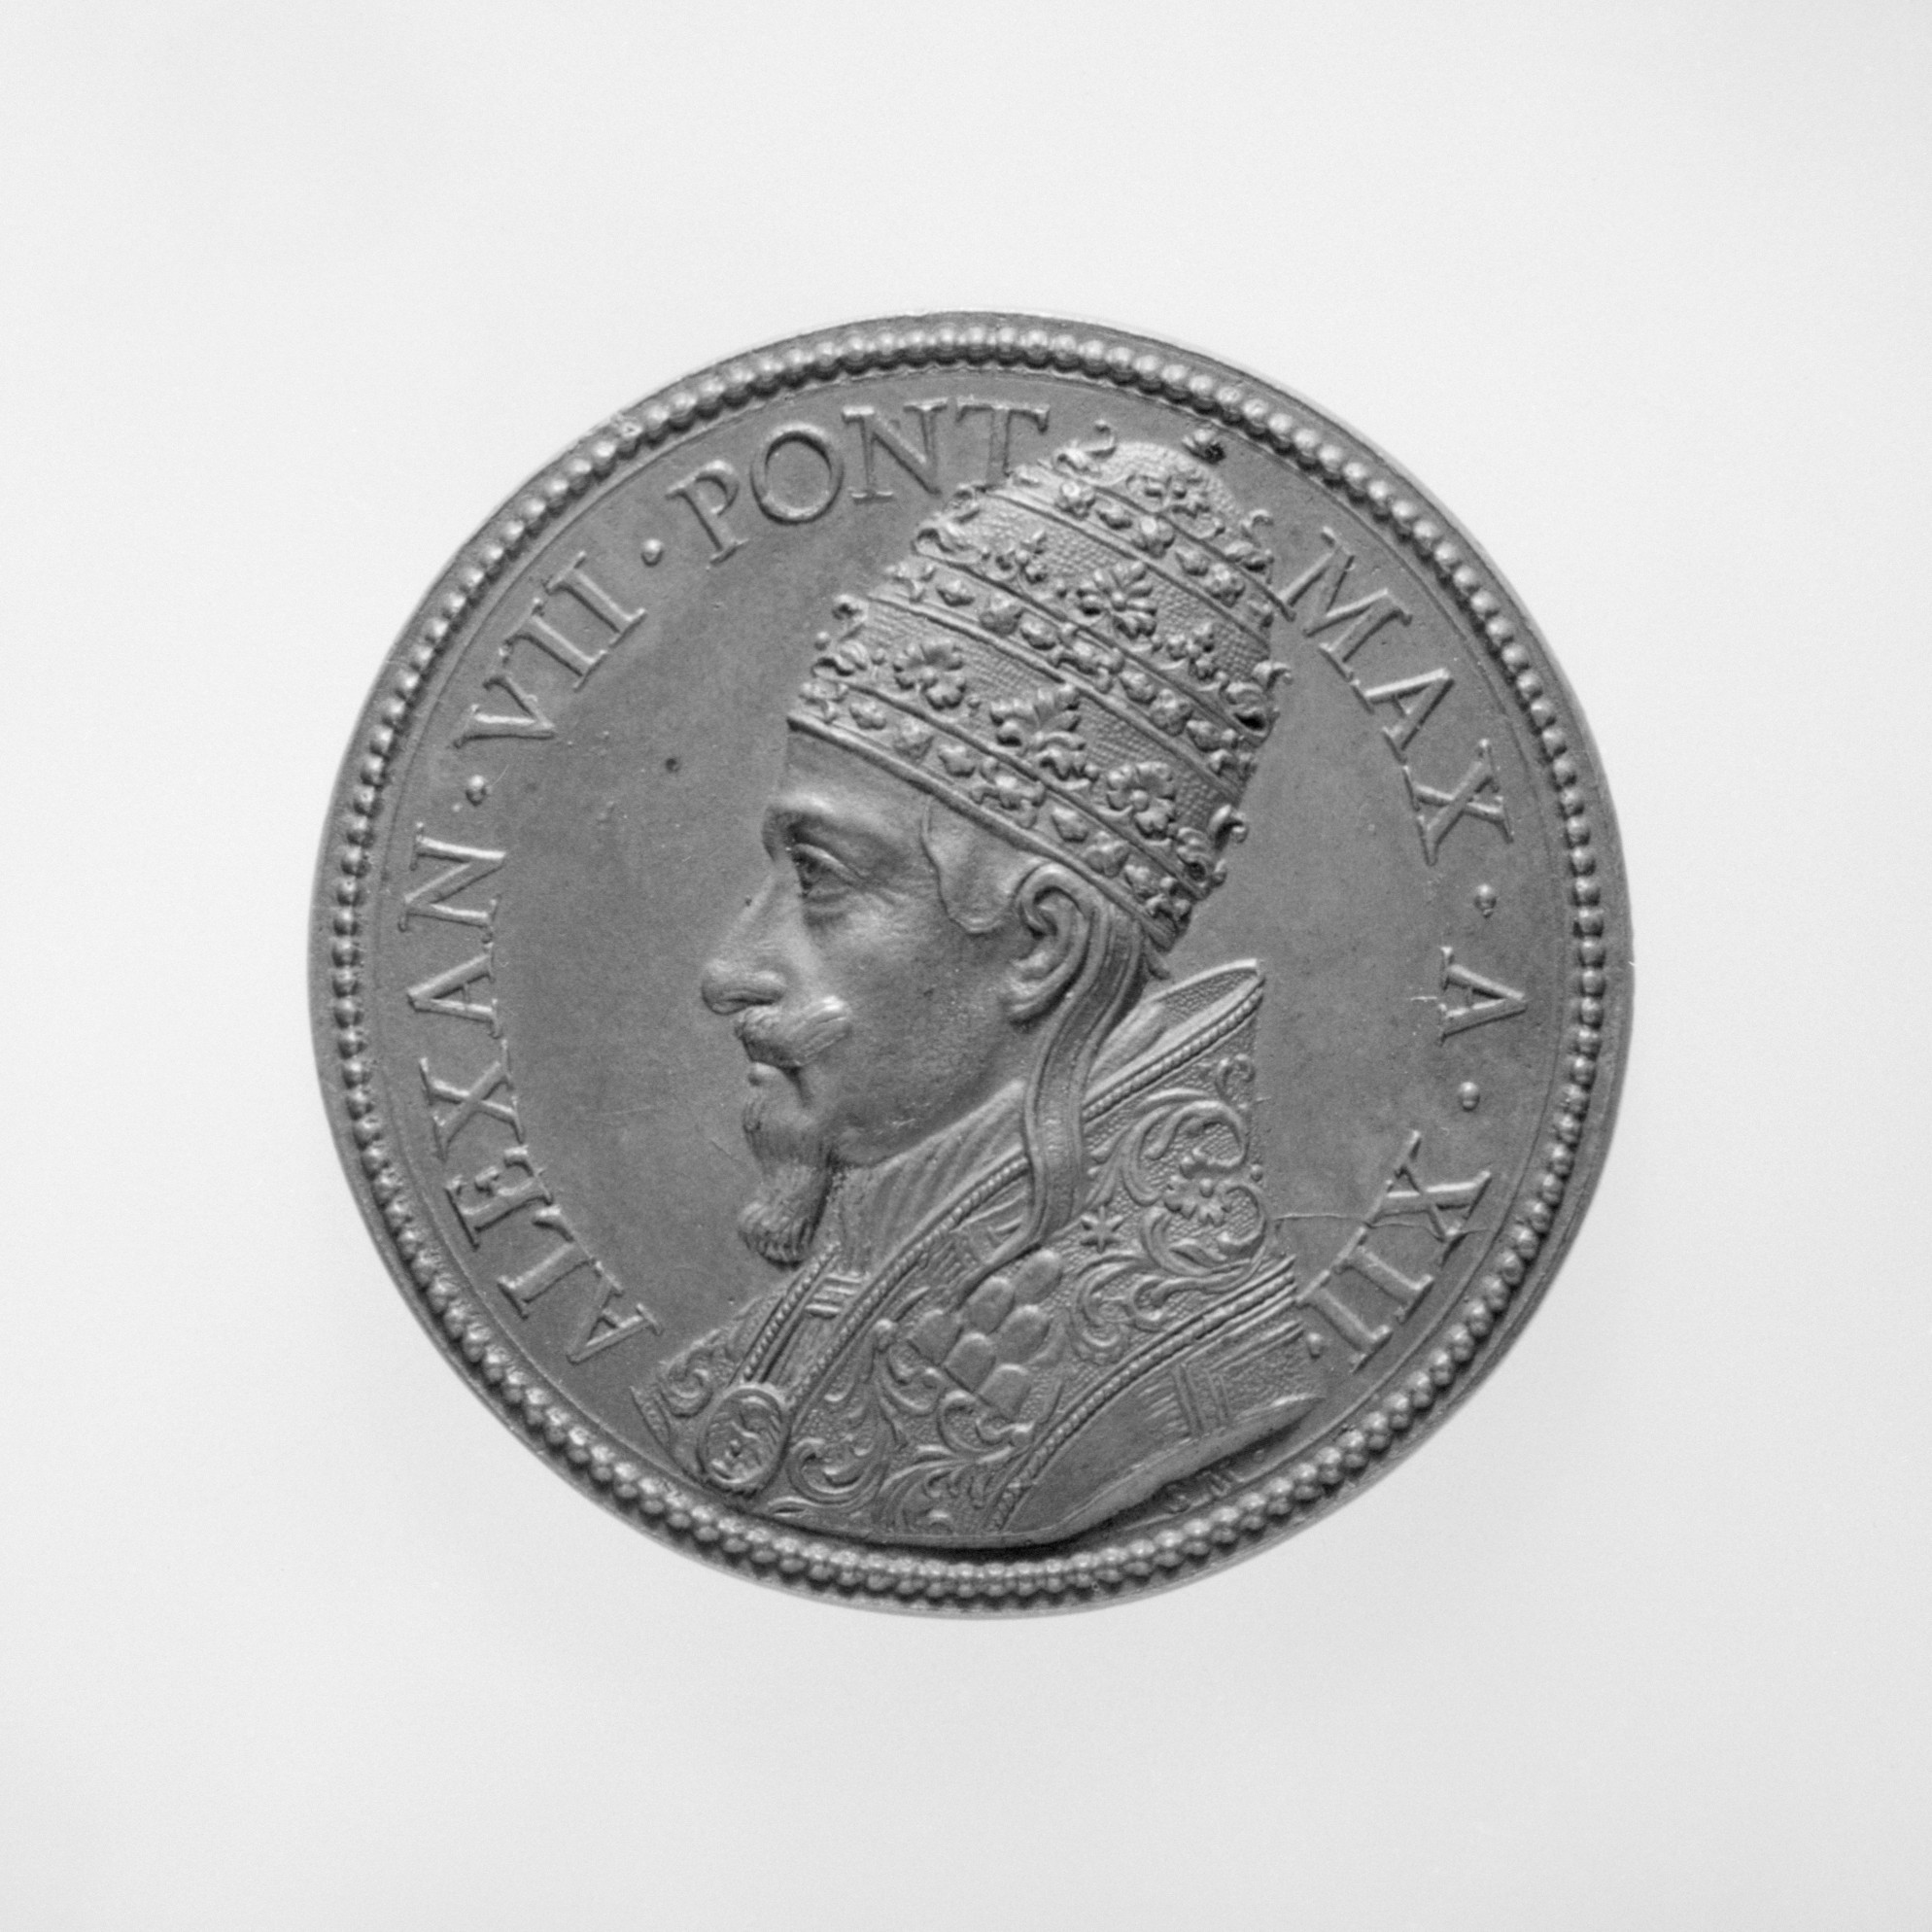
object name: medal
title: Alexander VII (Pope, 1655–67)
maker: gasparo morone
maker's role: artist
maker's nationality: italian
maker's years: 1569-1669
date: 1666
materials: bronze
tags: buildings,profiles,popes